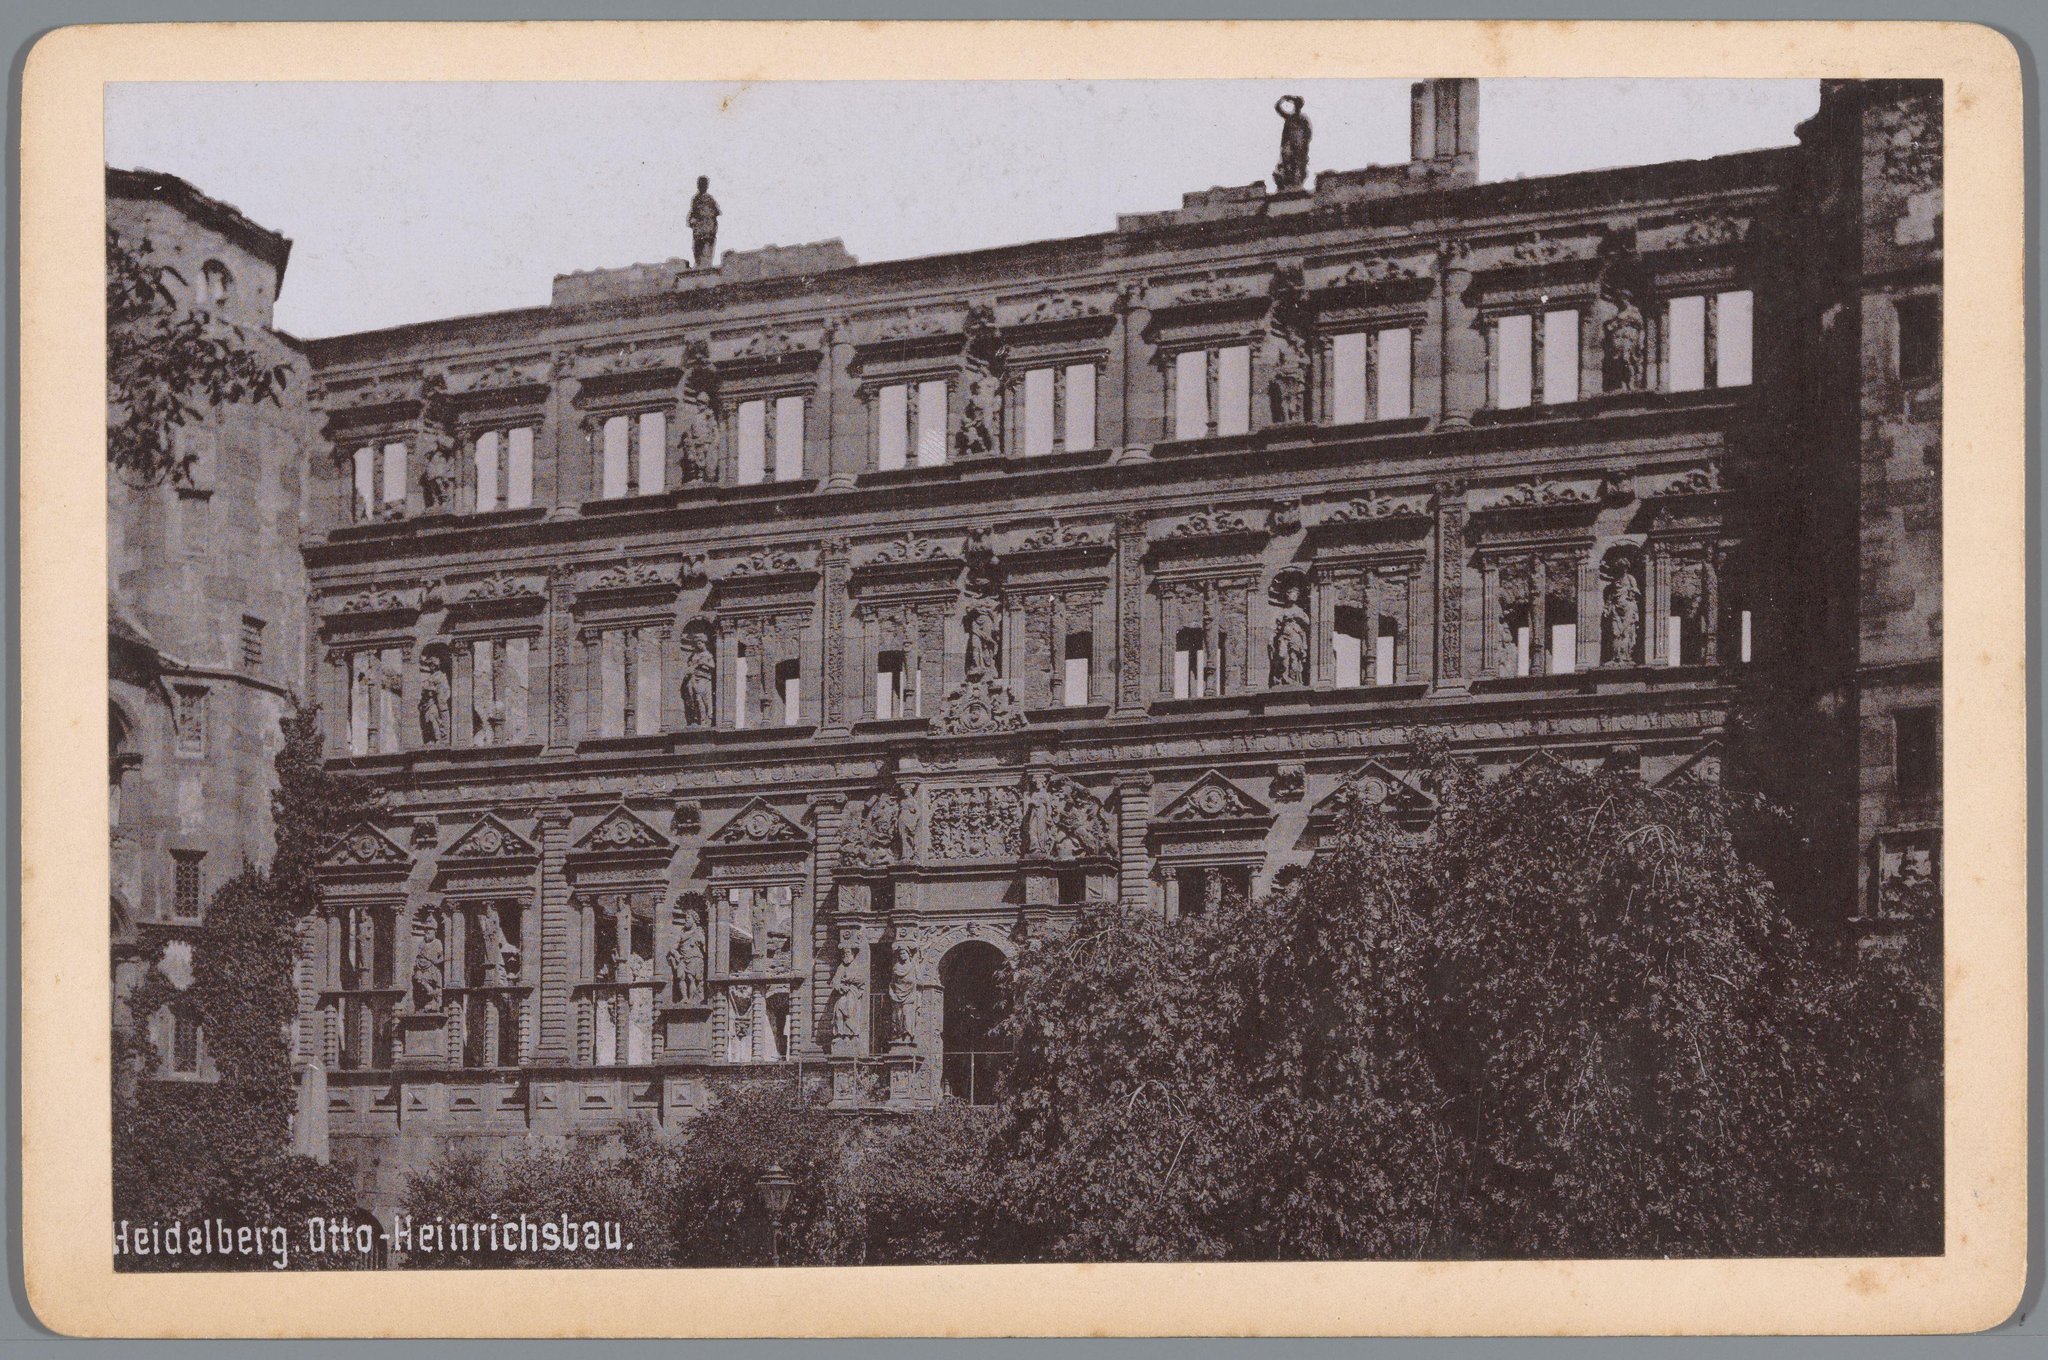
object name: cabinet photograph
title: Gezicht op Schloss Ottheinrichsbau in Heidelberg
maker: Anonymous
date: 1870-1900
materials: cardboard, paper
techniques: photograph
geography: heidelberg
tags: castle